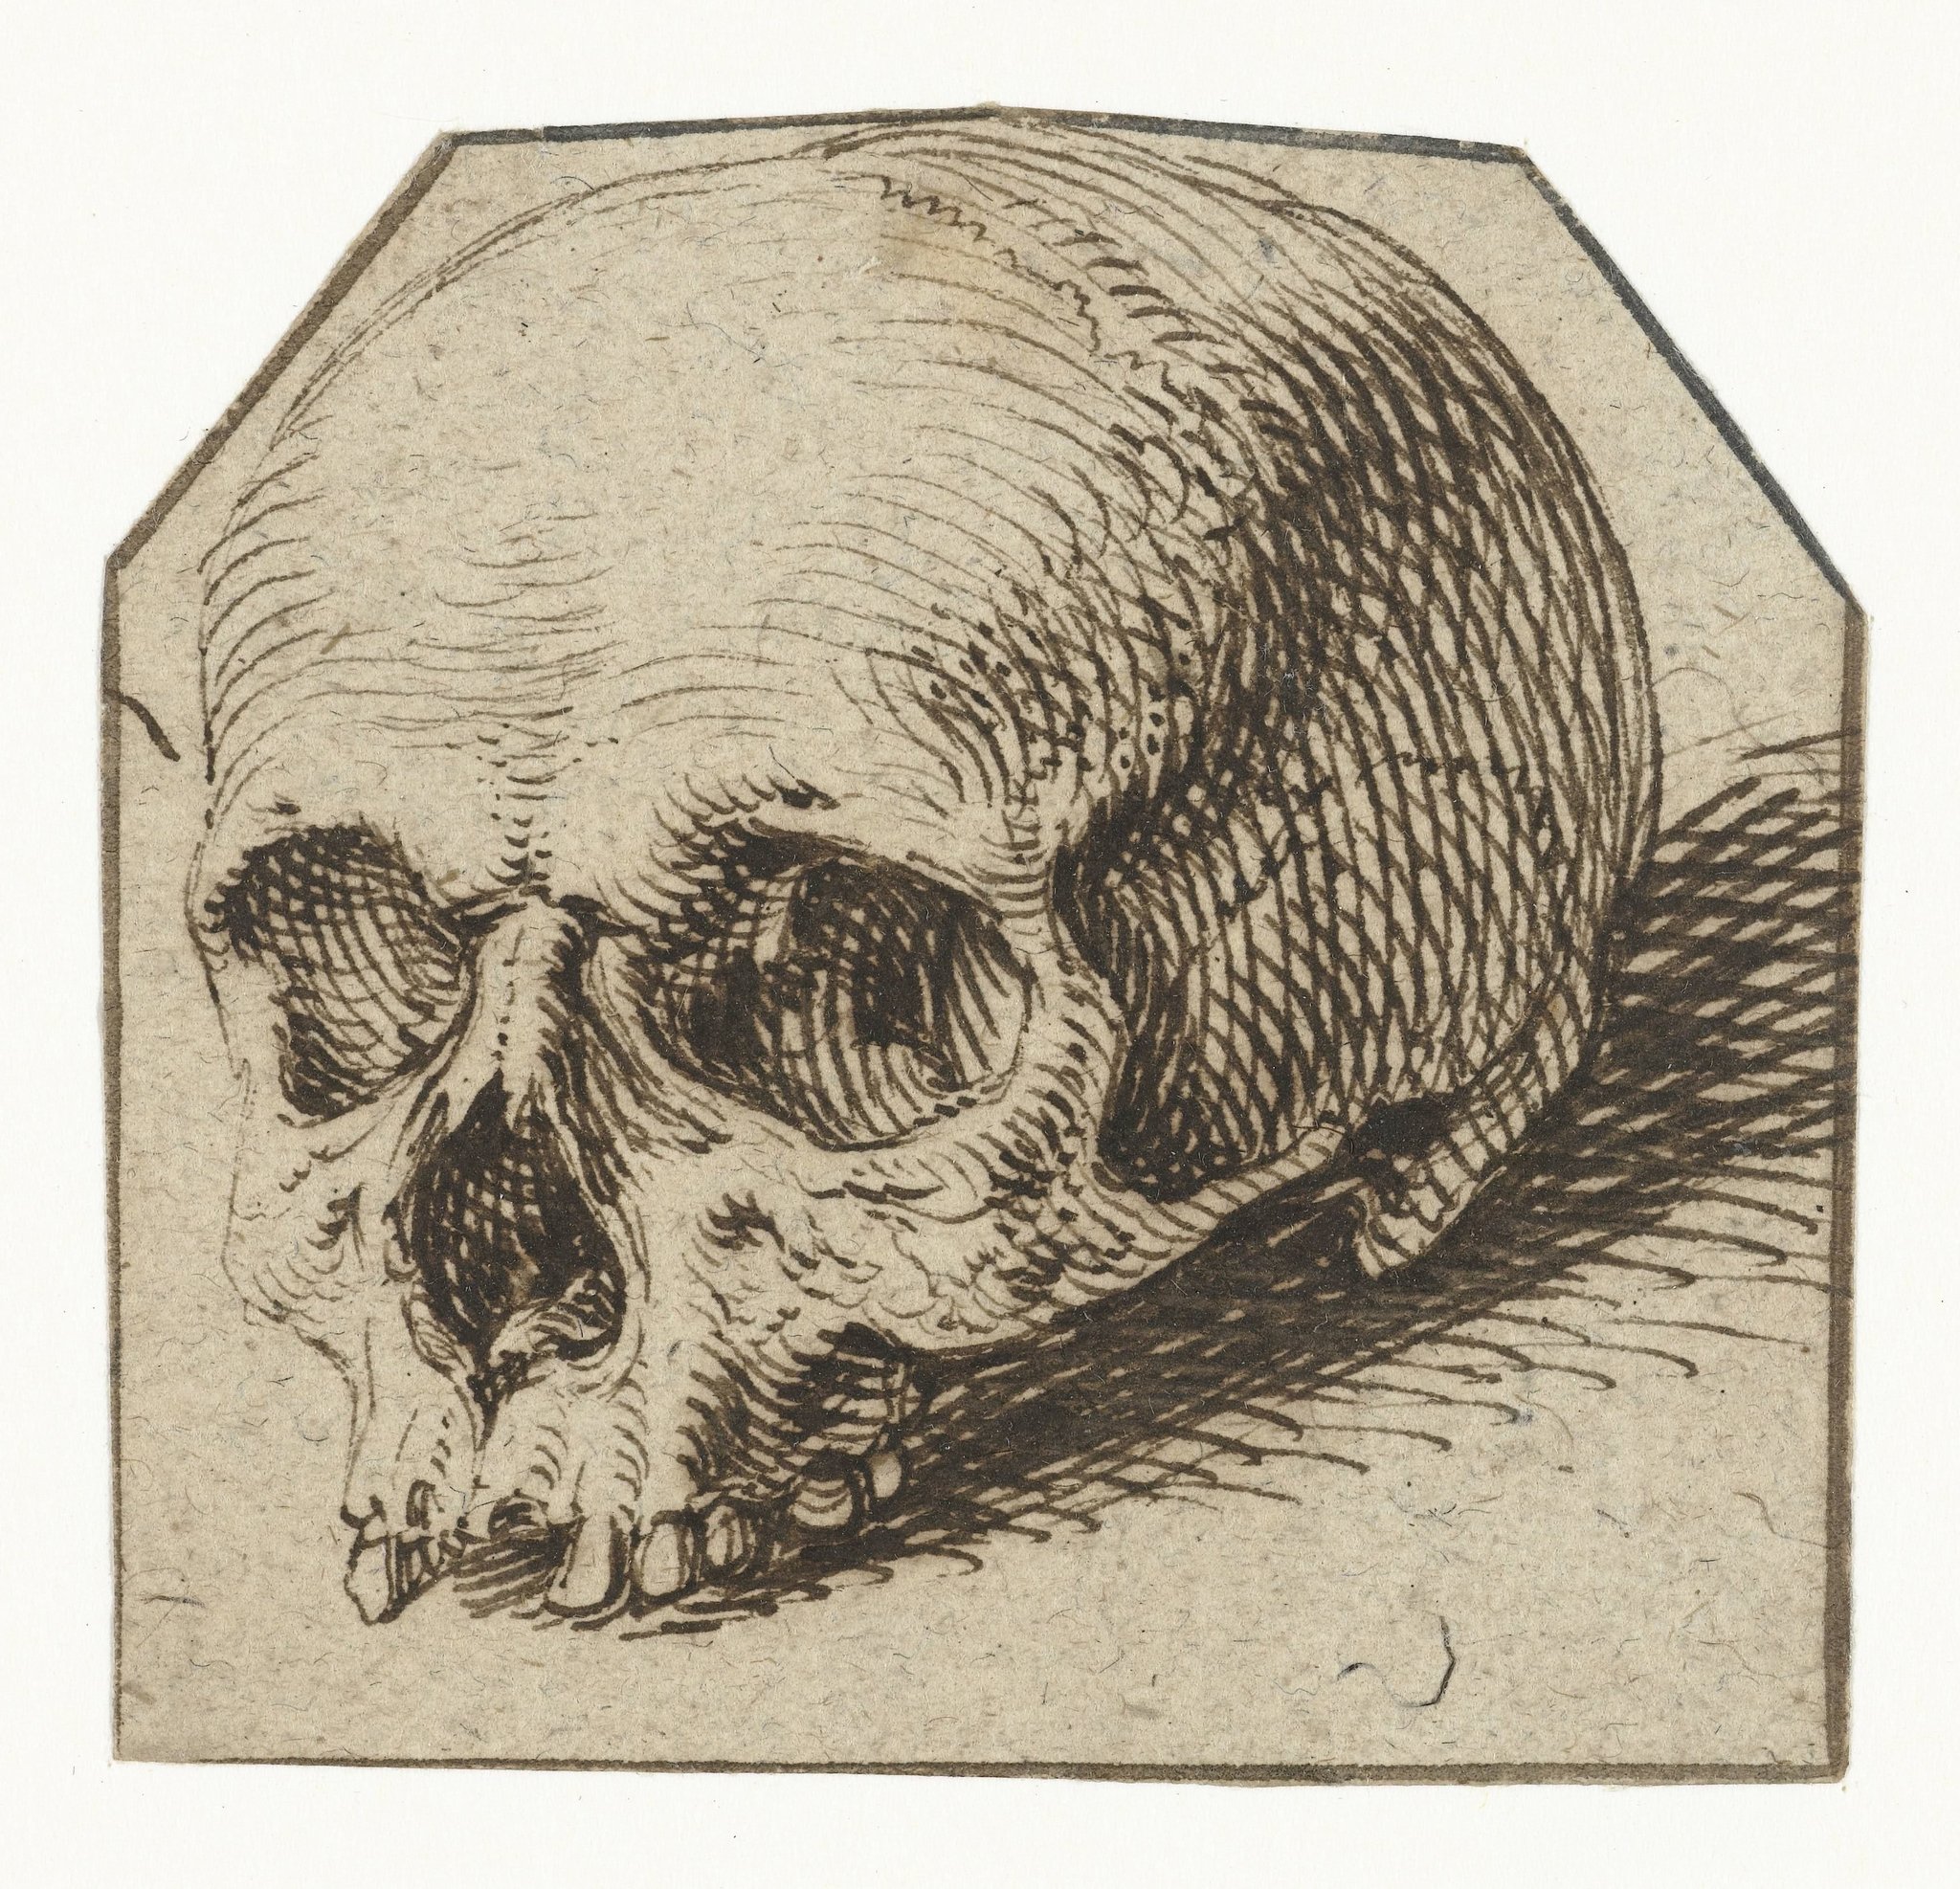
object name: drawing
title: Studie van een schedel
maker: jacques de gheyn (ii)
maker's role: painter, print maker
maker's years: 1565-1629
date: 1575-1625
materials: paper, ink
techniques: pen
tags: (human) skull